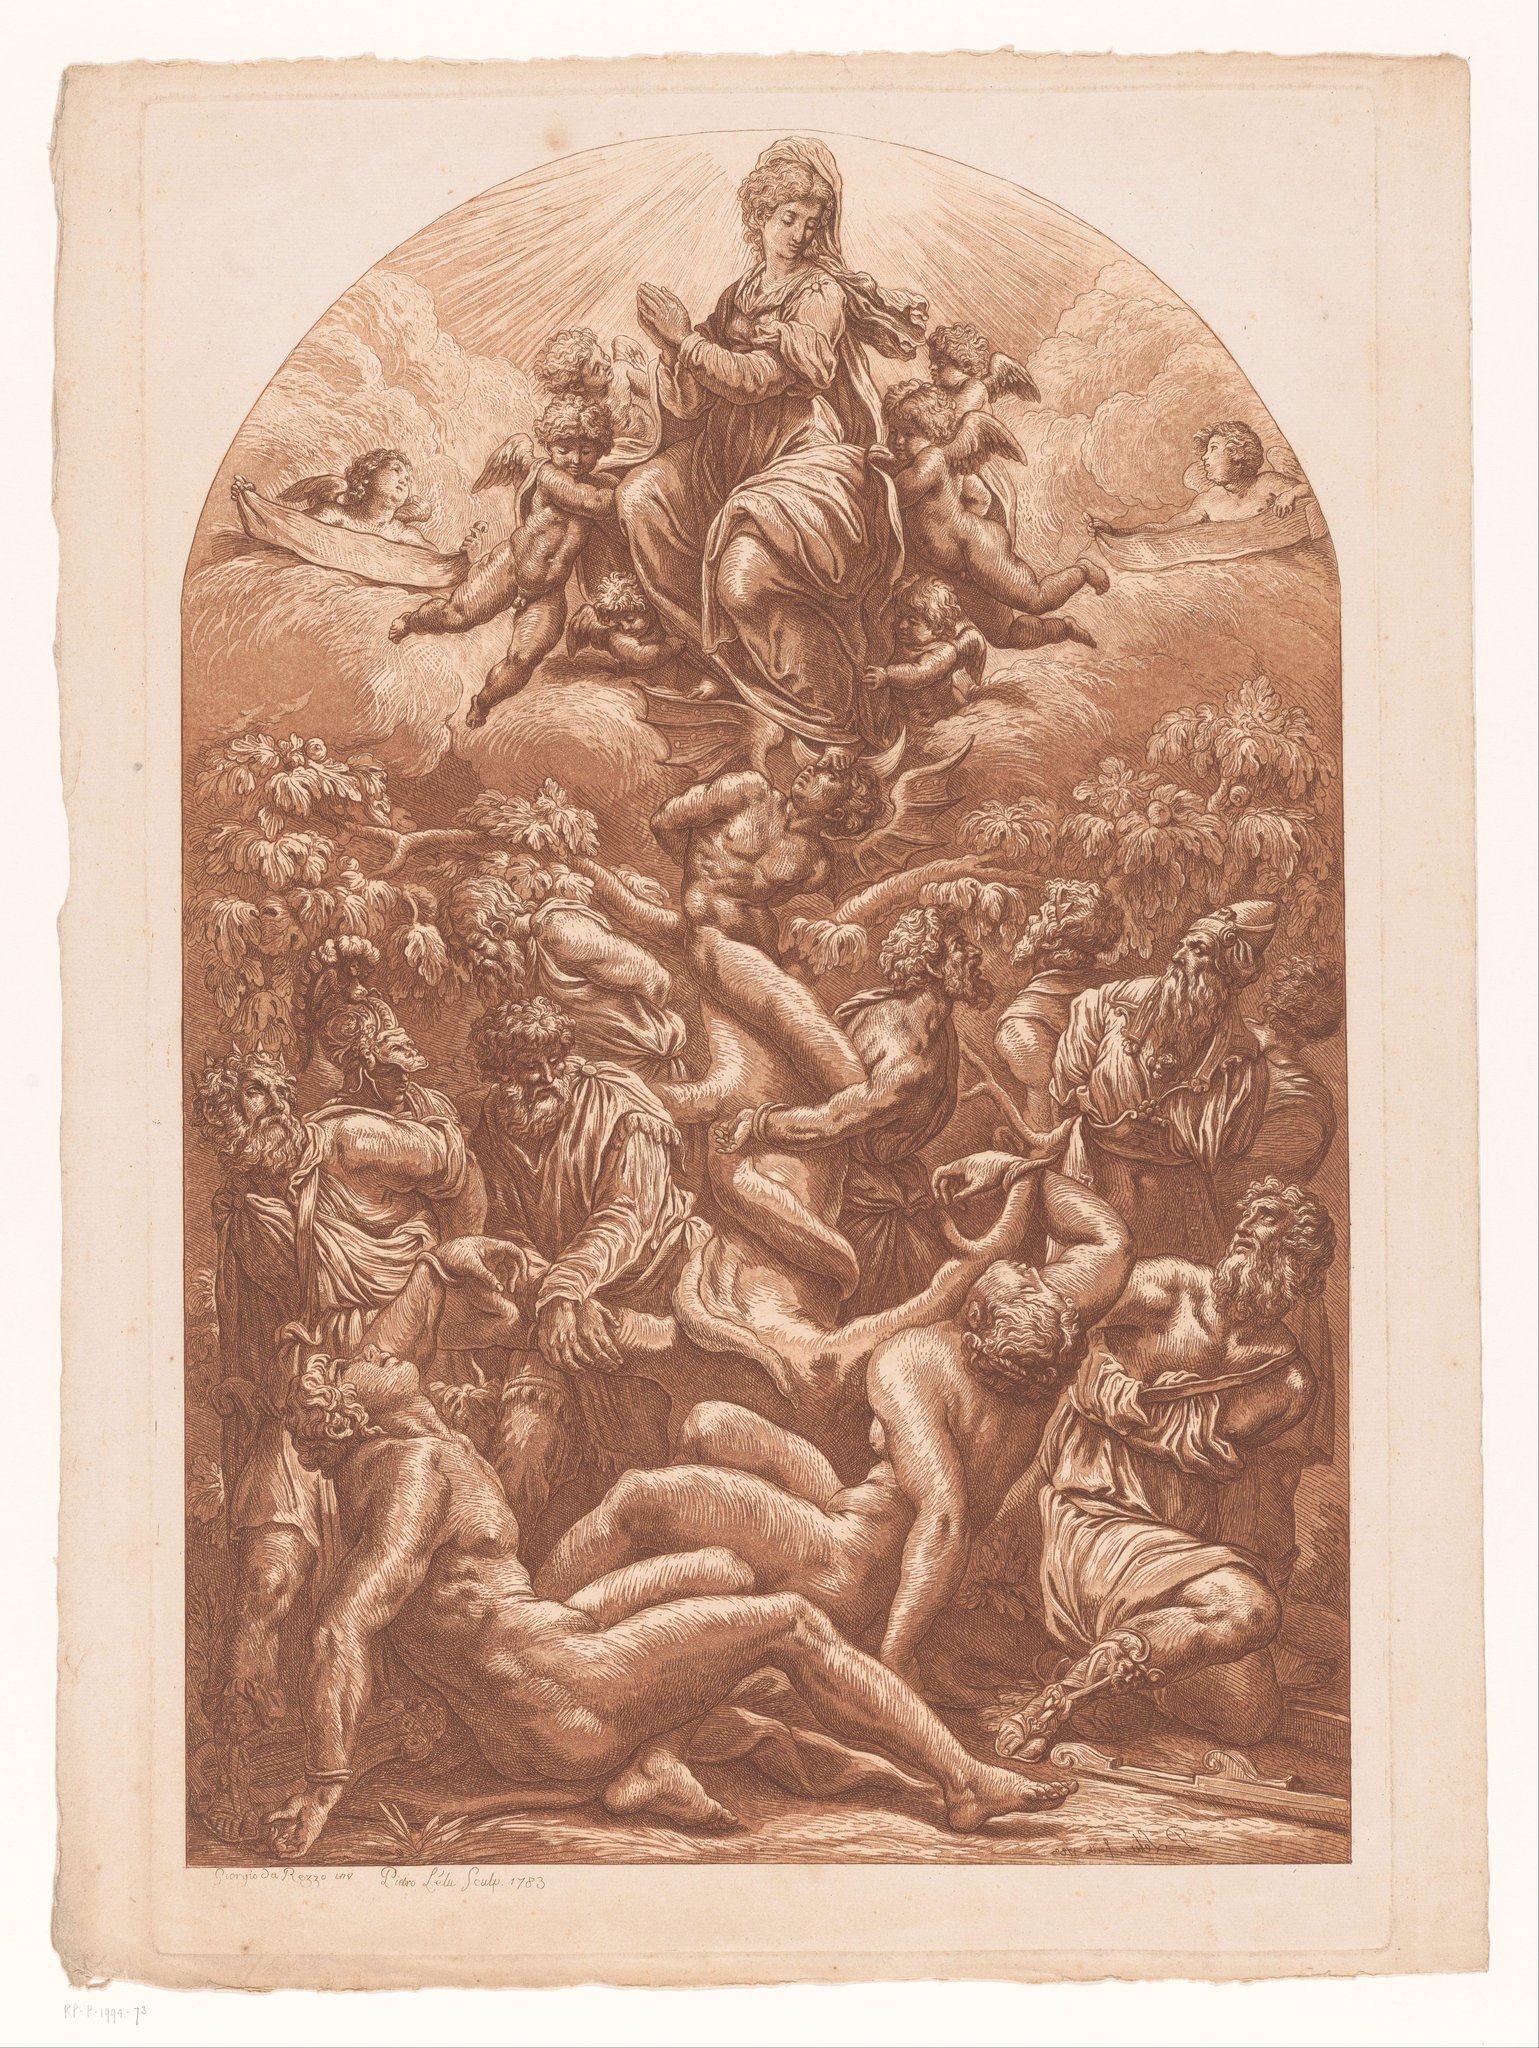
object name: print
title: Allegorie op de Onbevlekte Ontvangenis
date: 1783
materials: paper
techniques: aquatint, etching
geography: france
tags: 'immaculata', 'purisima': mary, usually standing on a crescent moon, descending from heaven, exempt from original sin (sometimes trampling serpent)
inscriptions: collector's mark: Lugt 2228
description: Onderaan zijn Adam en Eva vastgebonden aan de boom van de kennis van goed en kwaad met daarin de slang. Naast hen bevinden zich Mozes, koningen, priesters, een soldaat en overige figuren. Bovenaan de boom zweeft Maria met engelen op een wolk. Met haar linkervoet staat zij op een halve maan en vertrapt zij de slang in de boom.